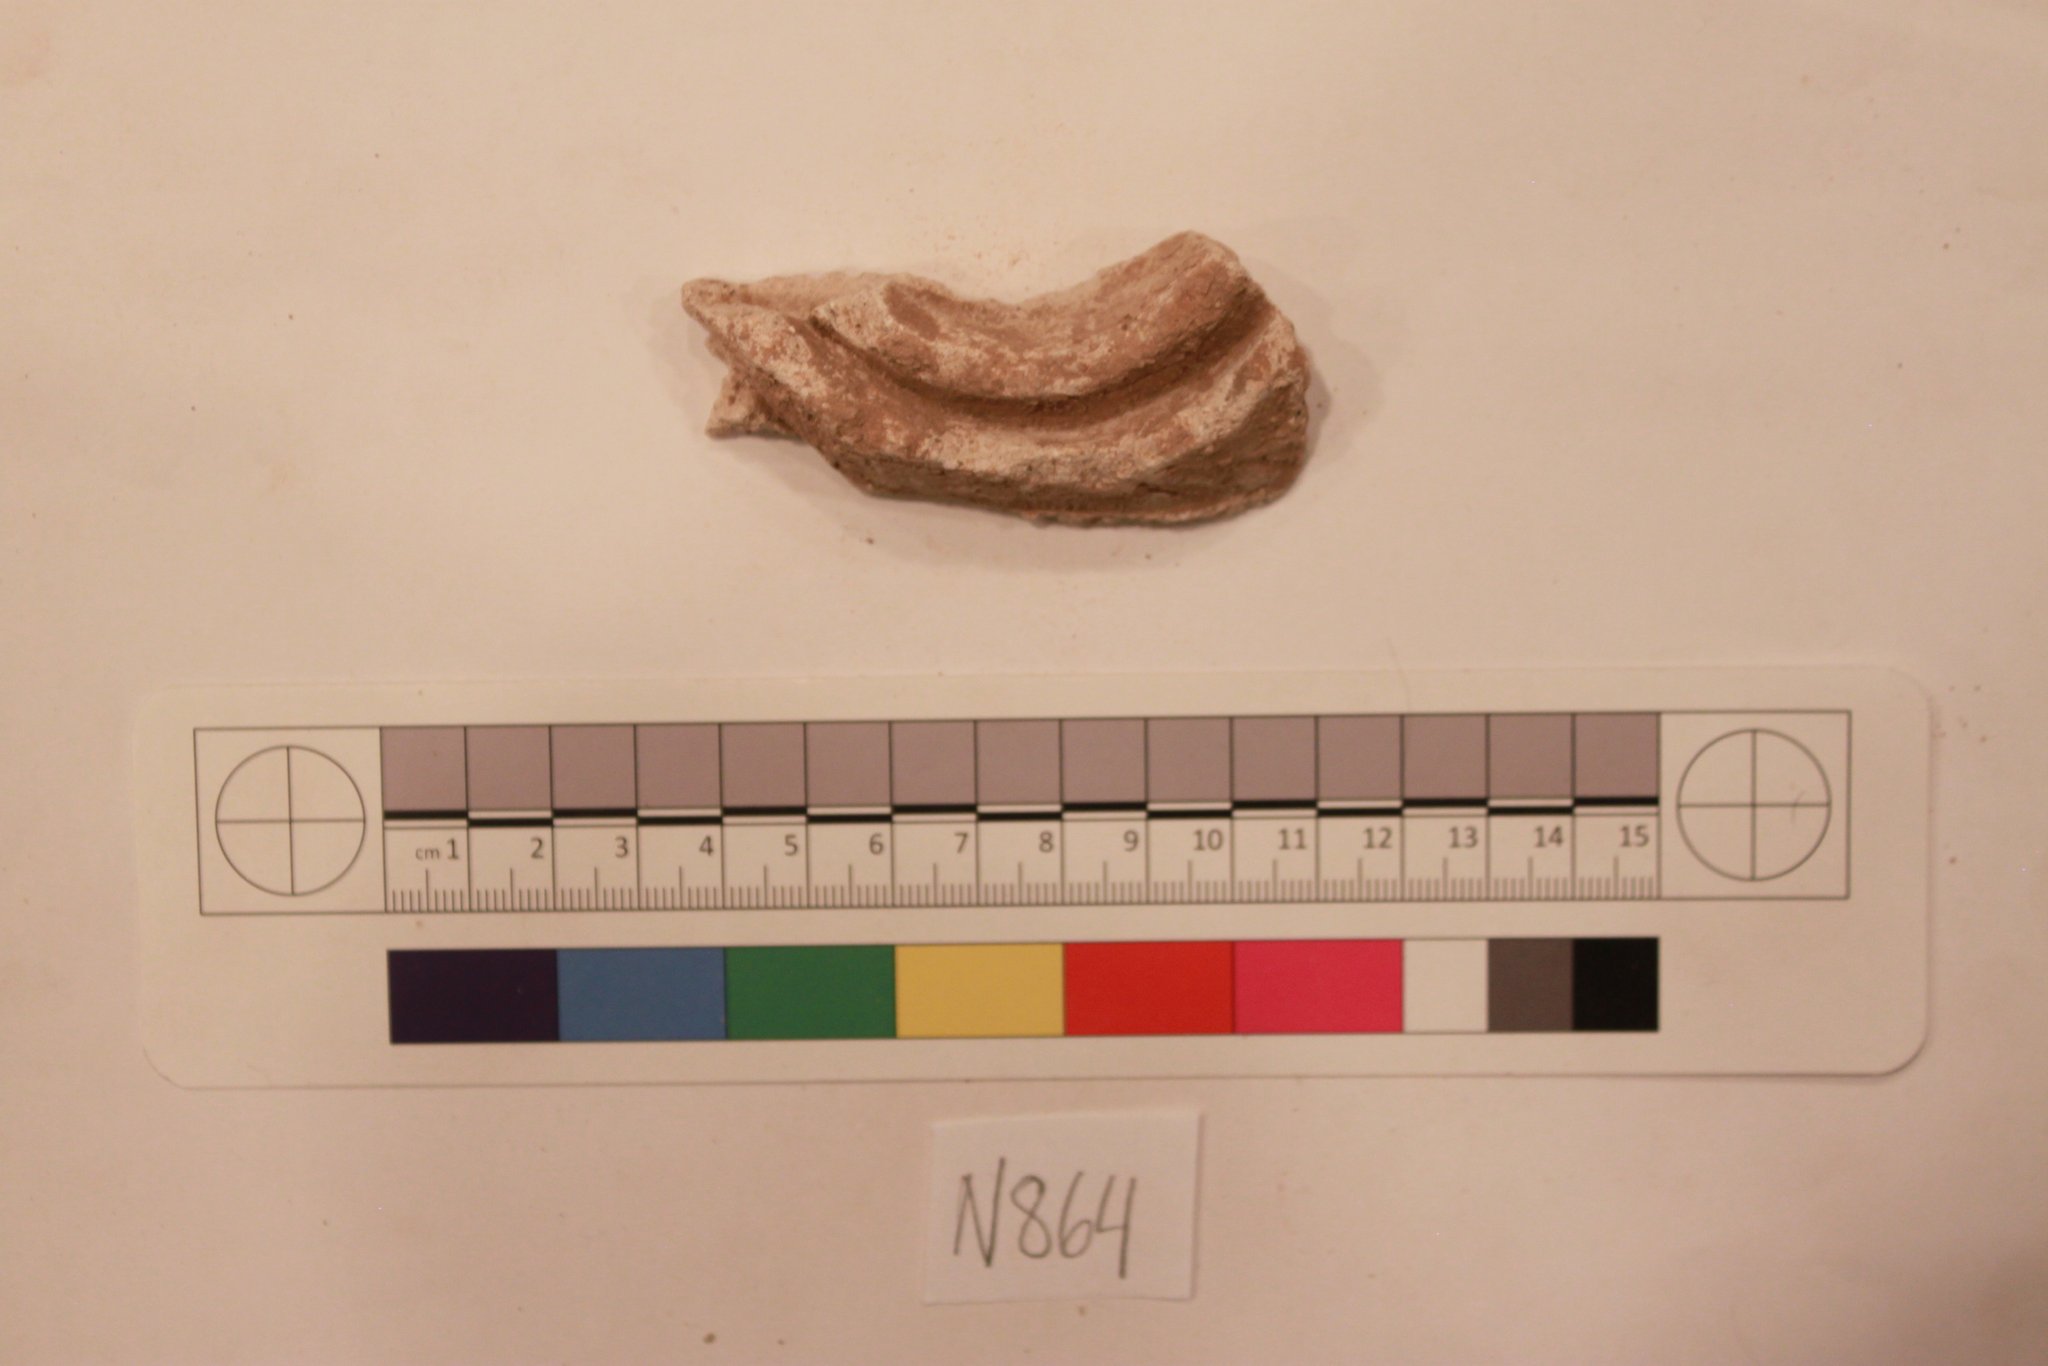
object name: fragment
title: Stucco Fragment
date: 701-1200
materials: plaster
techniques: carving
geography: iran